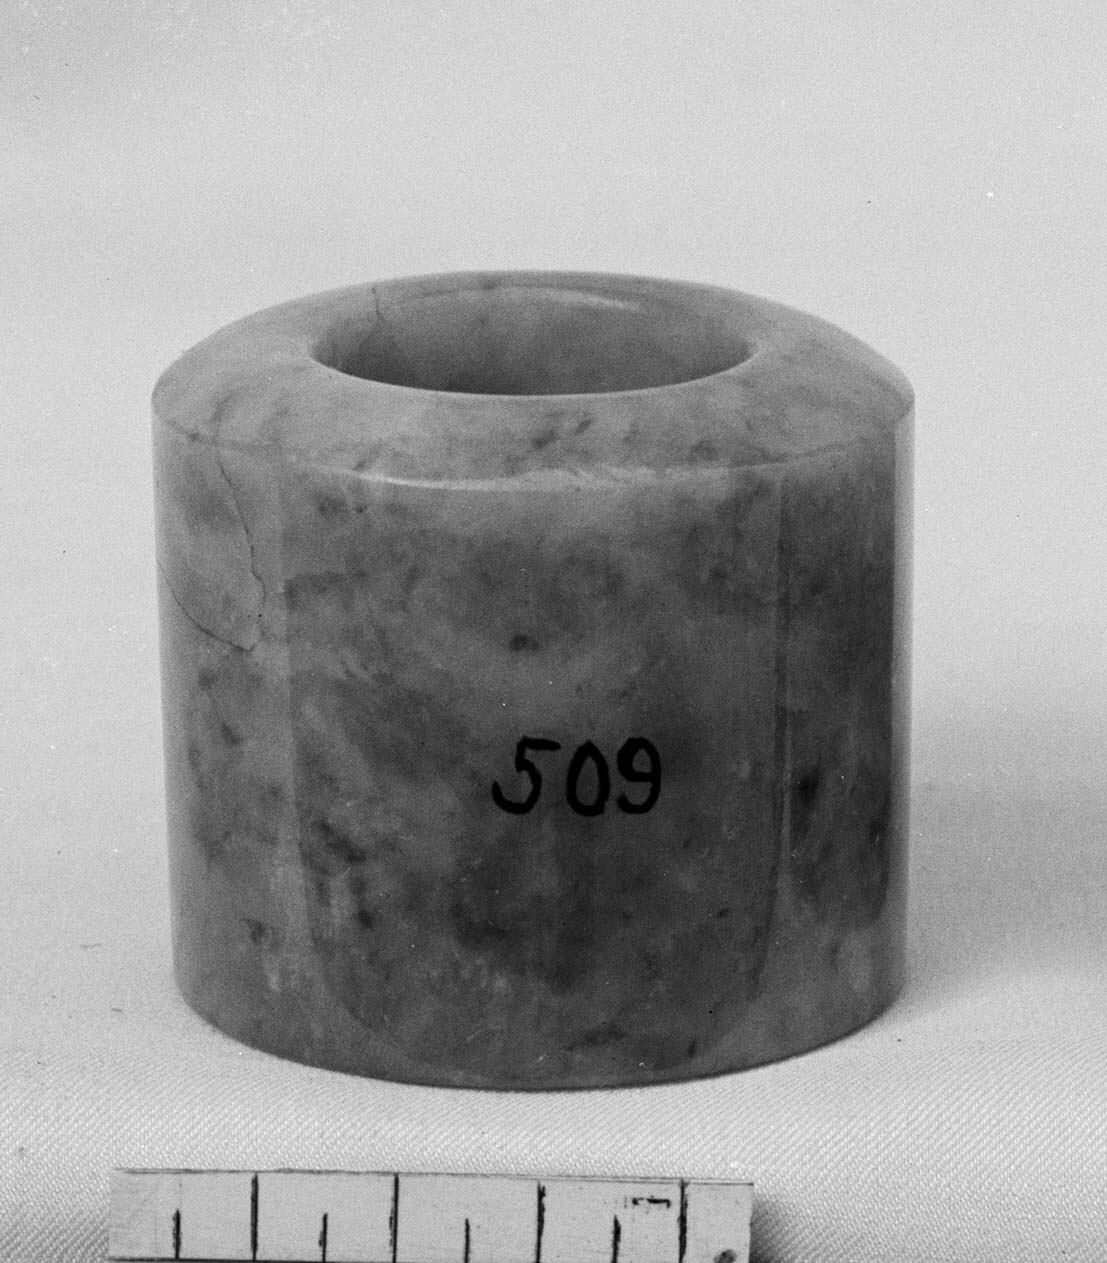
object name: thumb ring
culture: chinese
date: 1736-1795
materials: jade